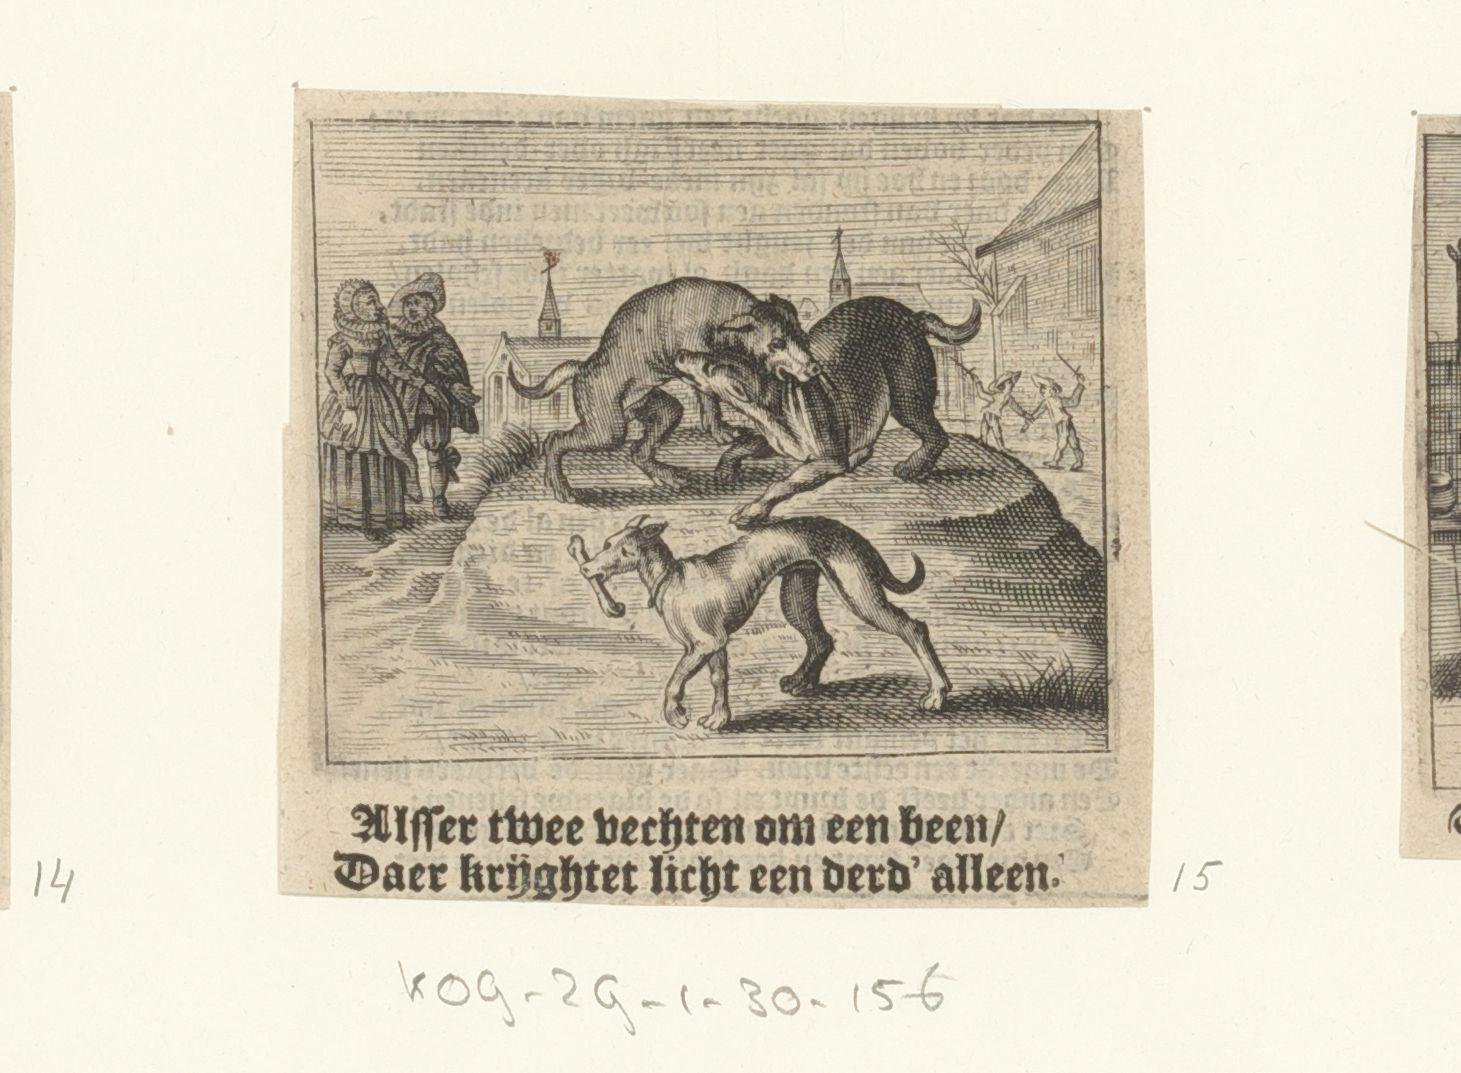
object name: print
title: Alsser twee vechten om een been / Daer krijghtet licht een derd' alleen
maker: Anonymous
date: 1635-1715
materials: paper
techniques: engraving, letterpress printing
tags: proverbs, sayings, etc., dog with bone, dog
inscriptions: stamp, collector's mark: Lugt 1641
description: Veel versies van dit embleem verschenen in verschillende uitgave van Spiegel van den Ouden ende Nieuwen Tydt. Zoals: Cats, Jacob. Spiegel van den Ouden ende Nieuwen-tijt, Bestaende uyt Spreeck-woorden (...). Dordrecht: Jacob Braat, 1647. Maar ook in andere publicaties (1665, 1671, 1715, 1722).